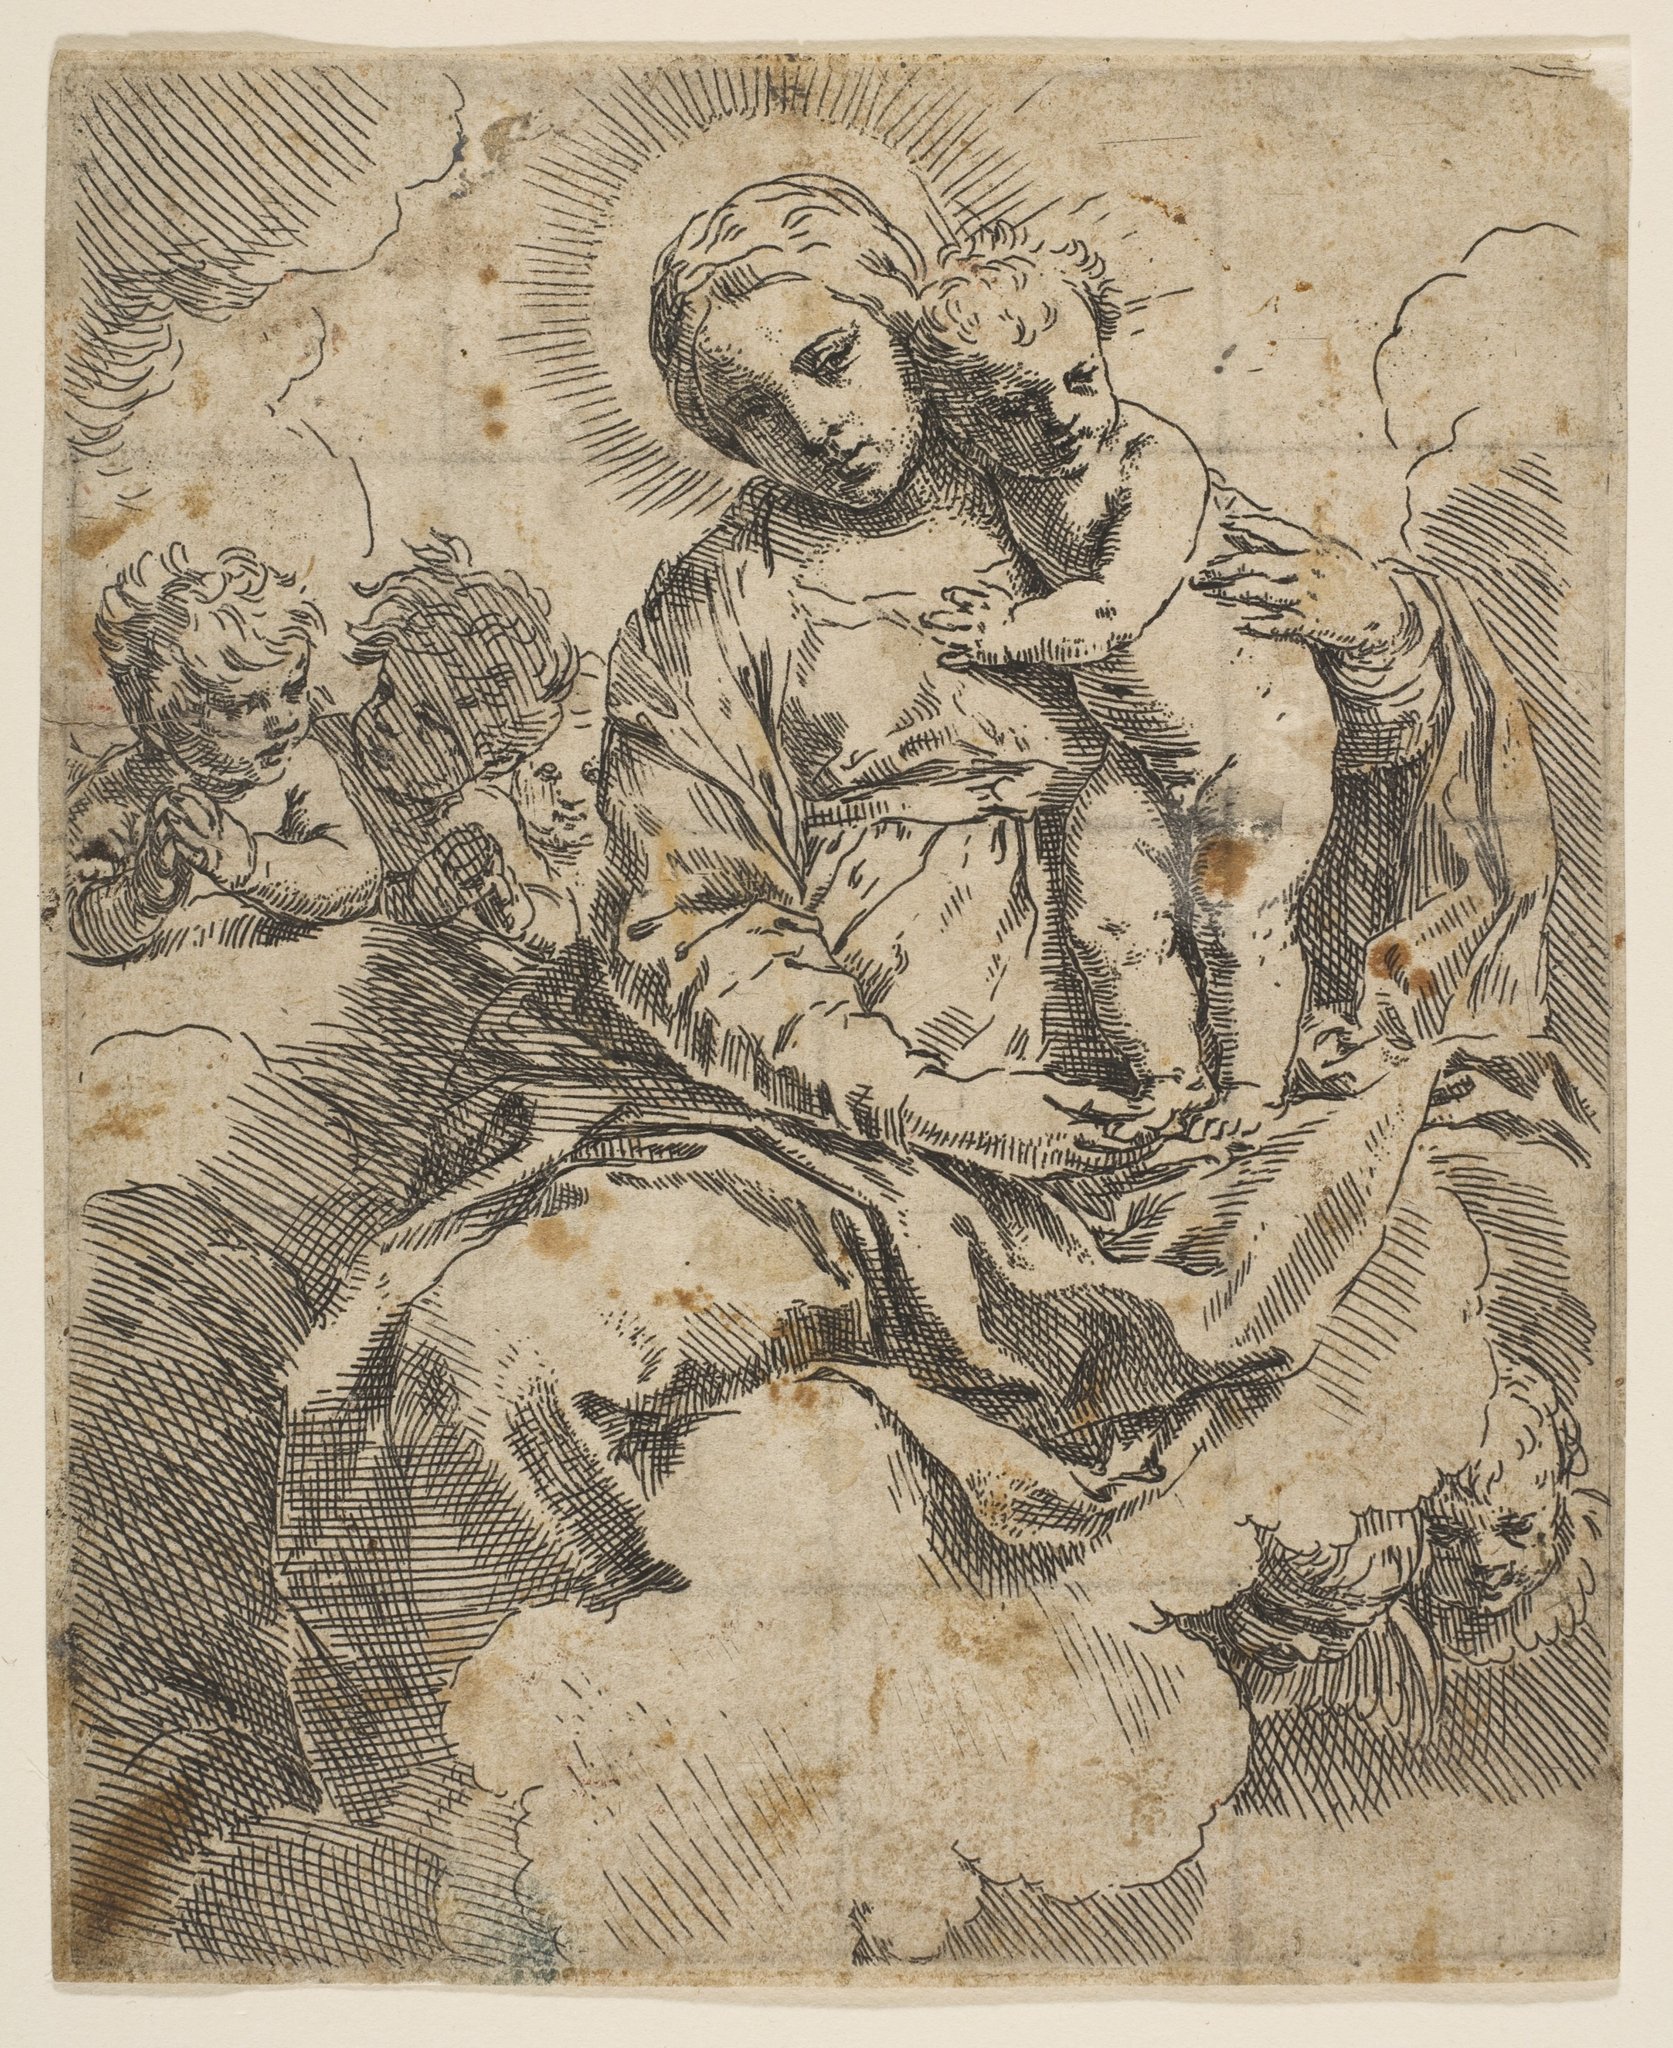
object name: print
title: Madonna and Child seated on clouds and surrounded by angels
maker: simone cantarini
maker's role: artist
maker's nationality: italian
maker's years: 1612-1648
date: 1639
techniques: etching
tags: angels,madonna and child